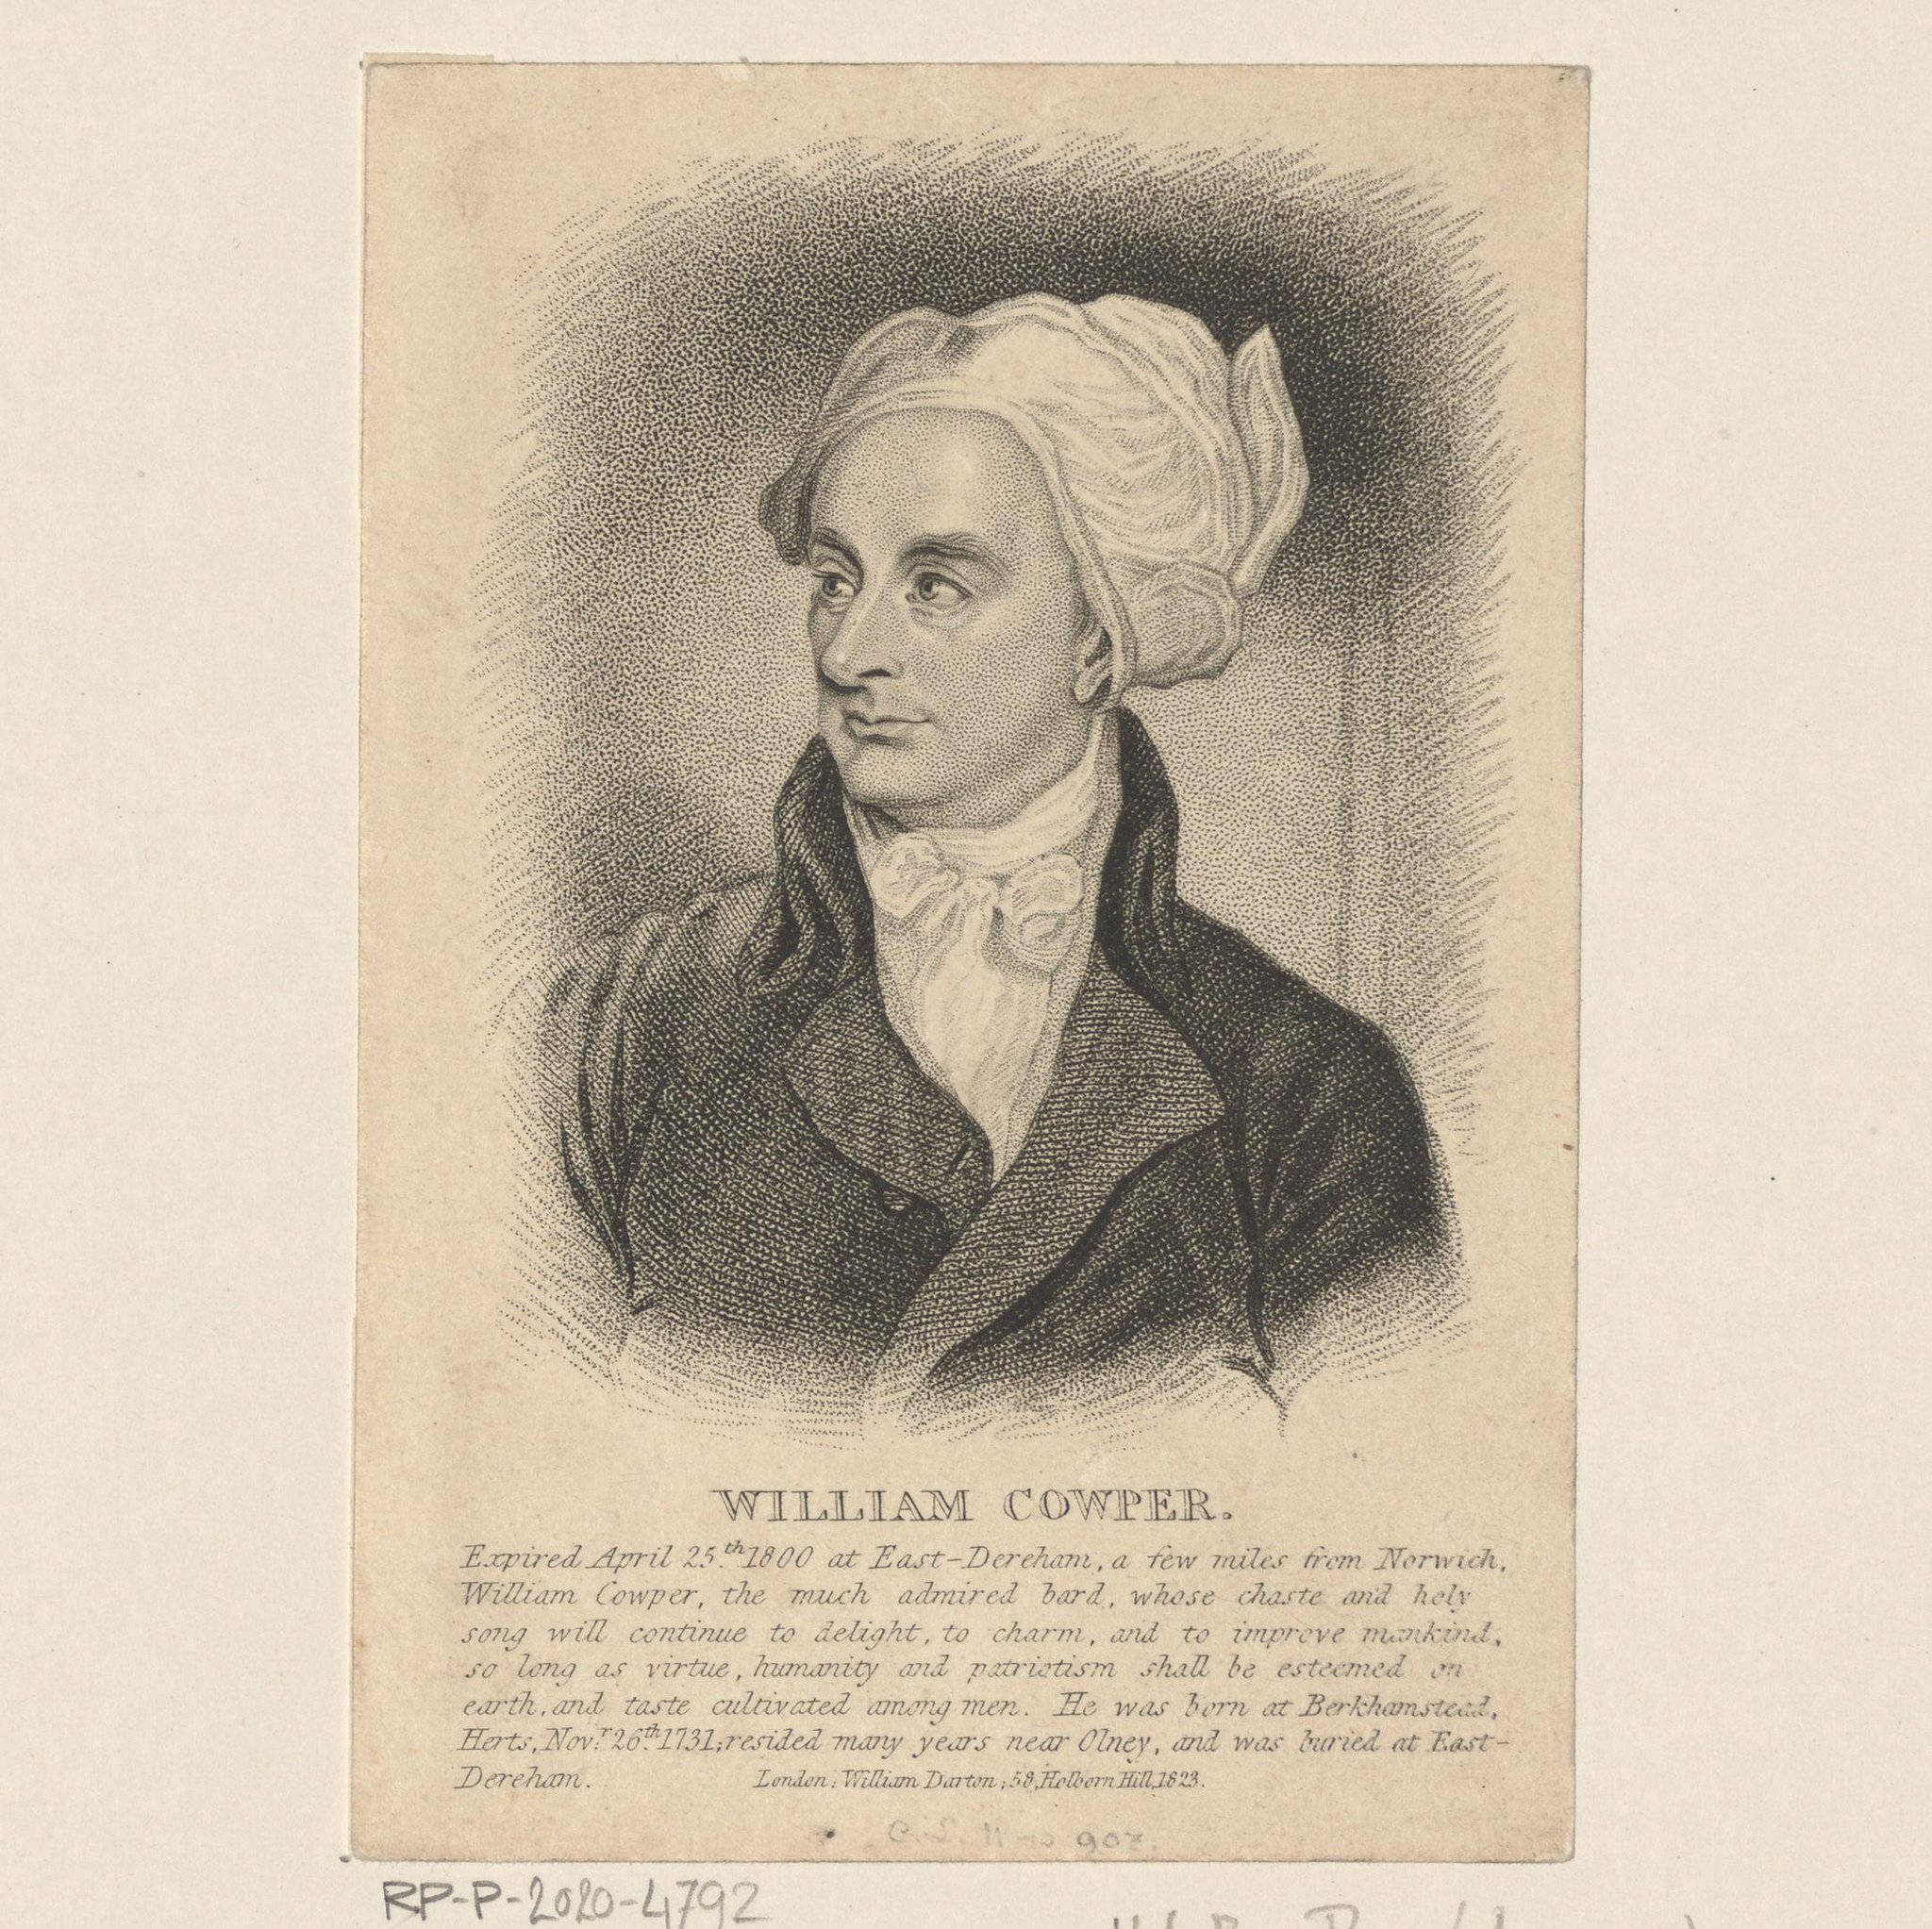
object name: print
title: Portret van William Cowper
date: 1823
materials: paper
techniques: engraving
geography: london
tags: william cowper, historical persons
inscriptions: date